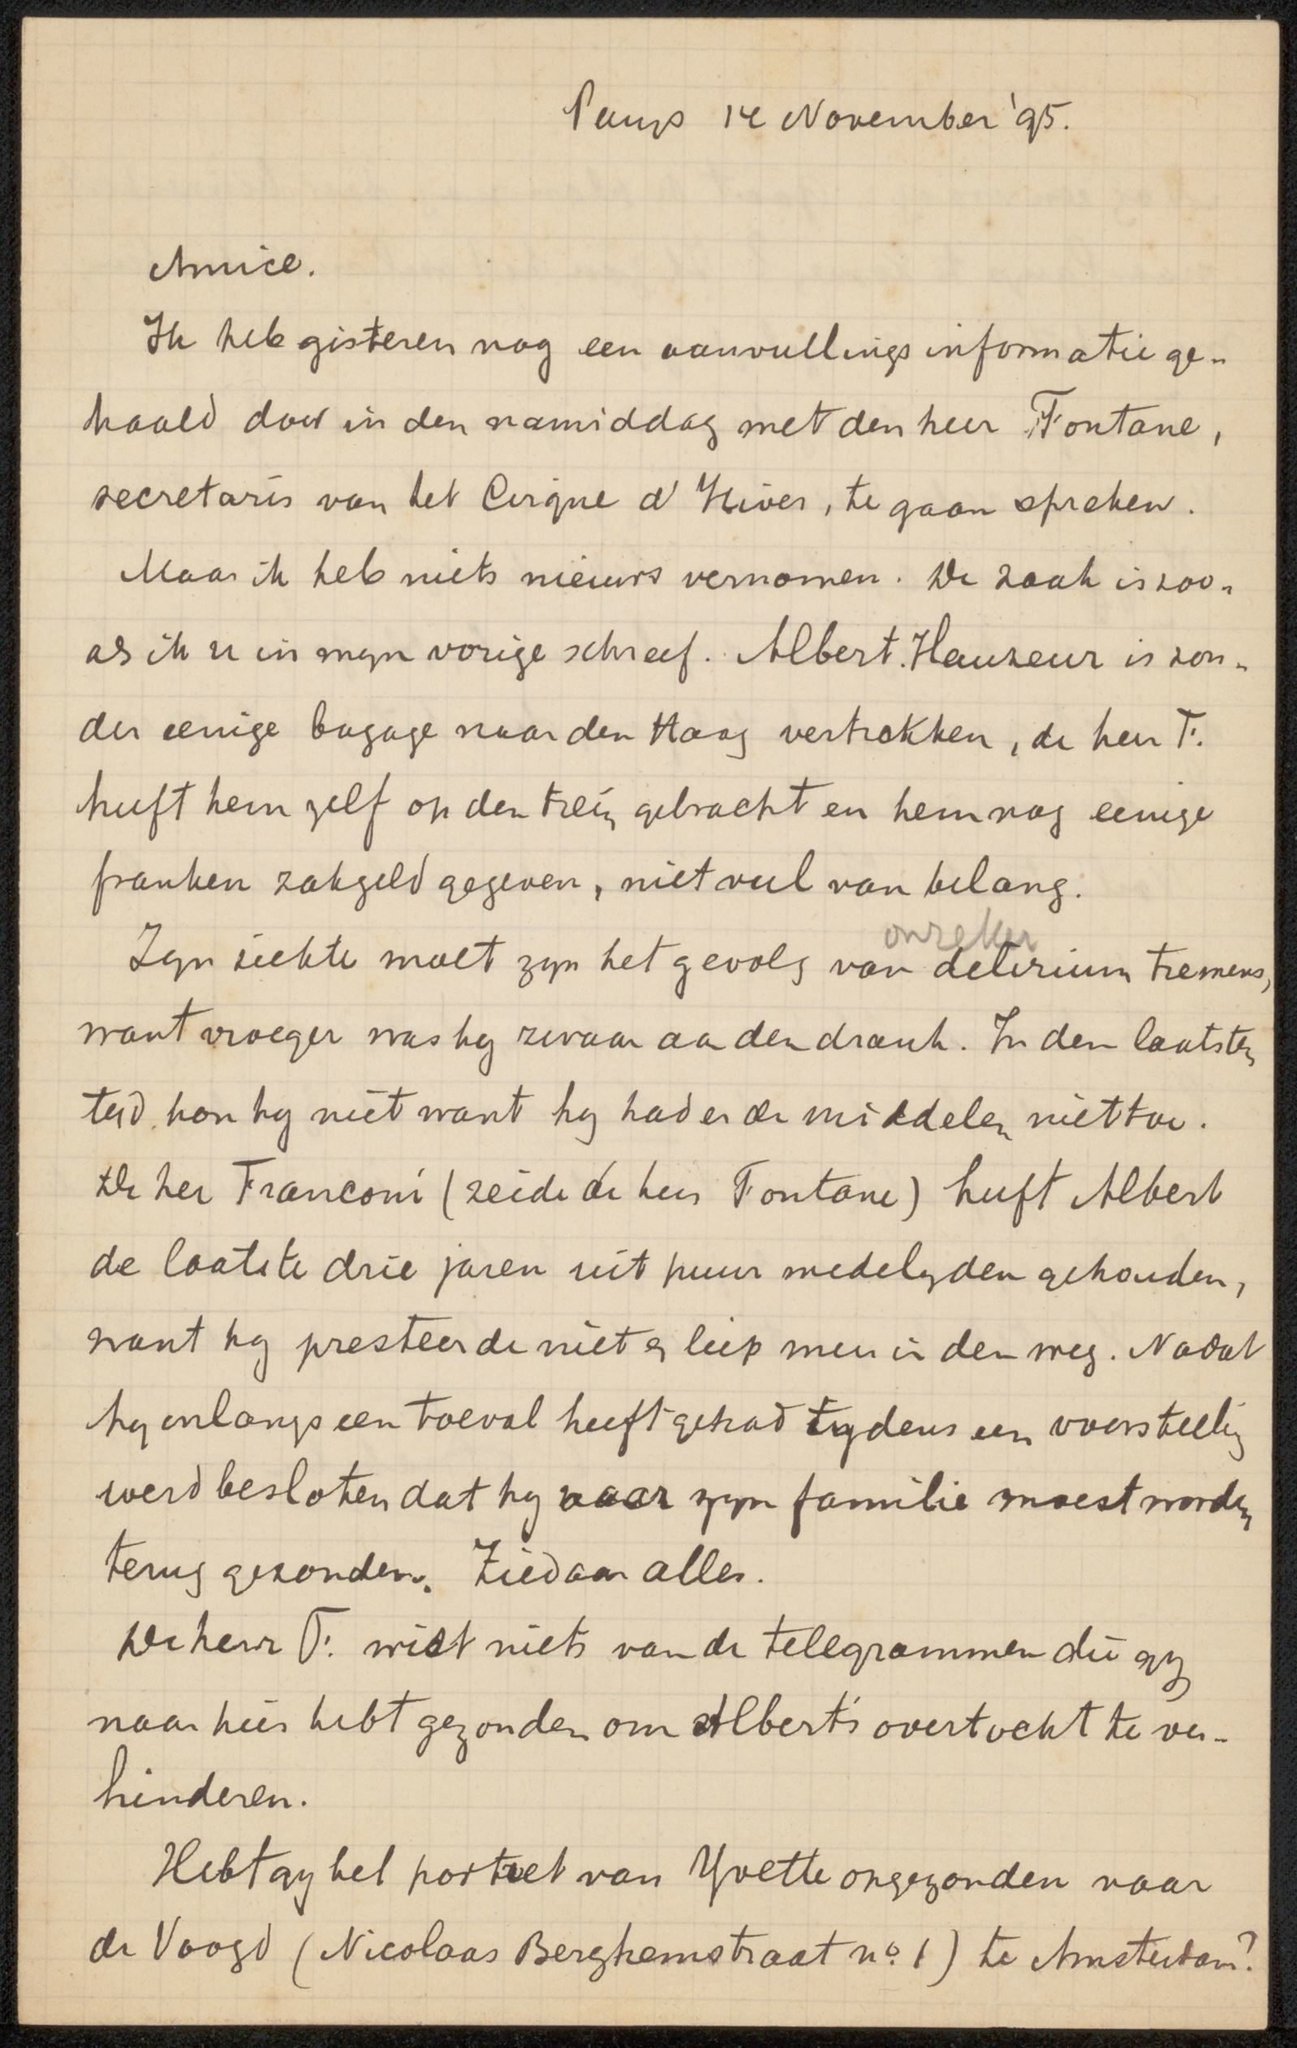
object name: letter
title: Brief aan Philip Zilcken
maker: charles snabilié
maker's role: journalist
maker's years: 1856-1927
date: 1895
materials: ink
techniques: pen, writing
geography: paris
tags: publisher, amsterdam, print maker, marius bauer, the hague, painter, draughtsman, philip zilcken, exhibition ~ art, diseases, historical persons (portraits and scenes from the life), money, paris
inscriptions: watermark